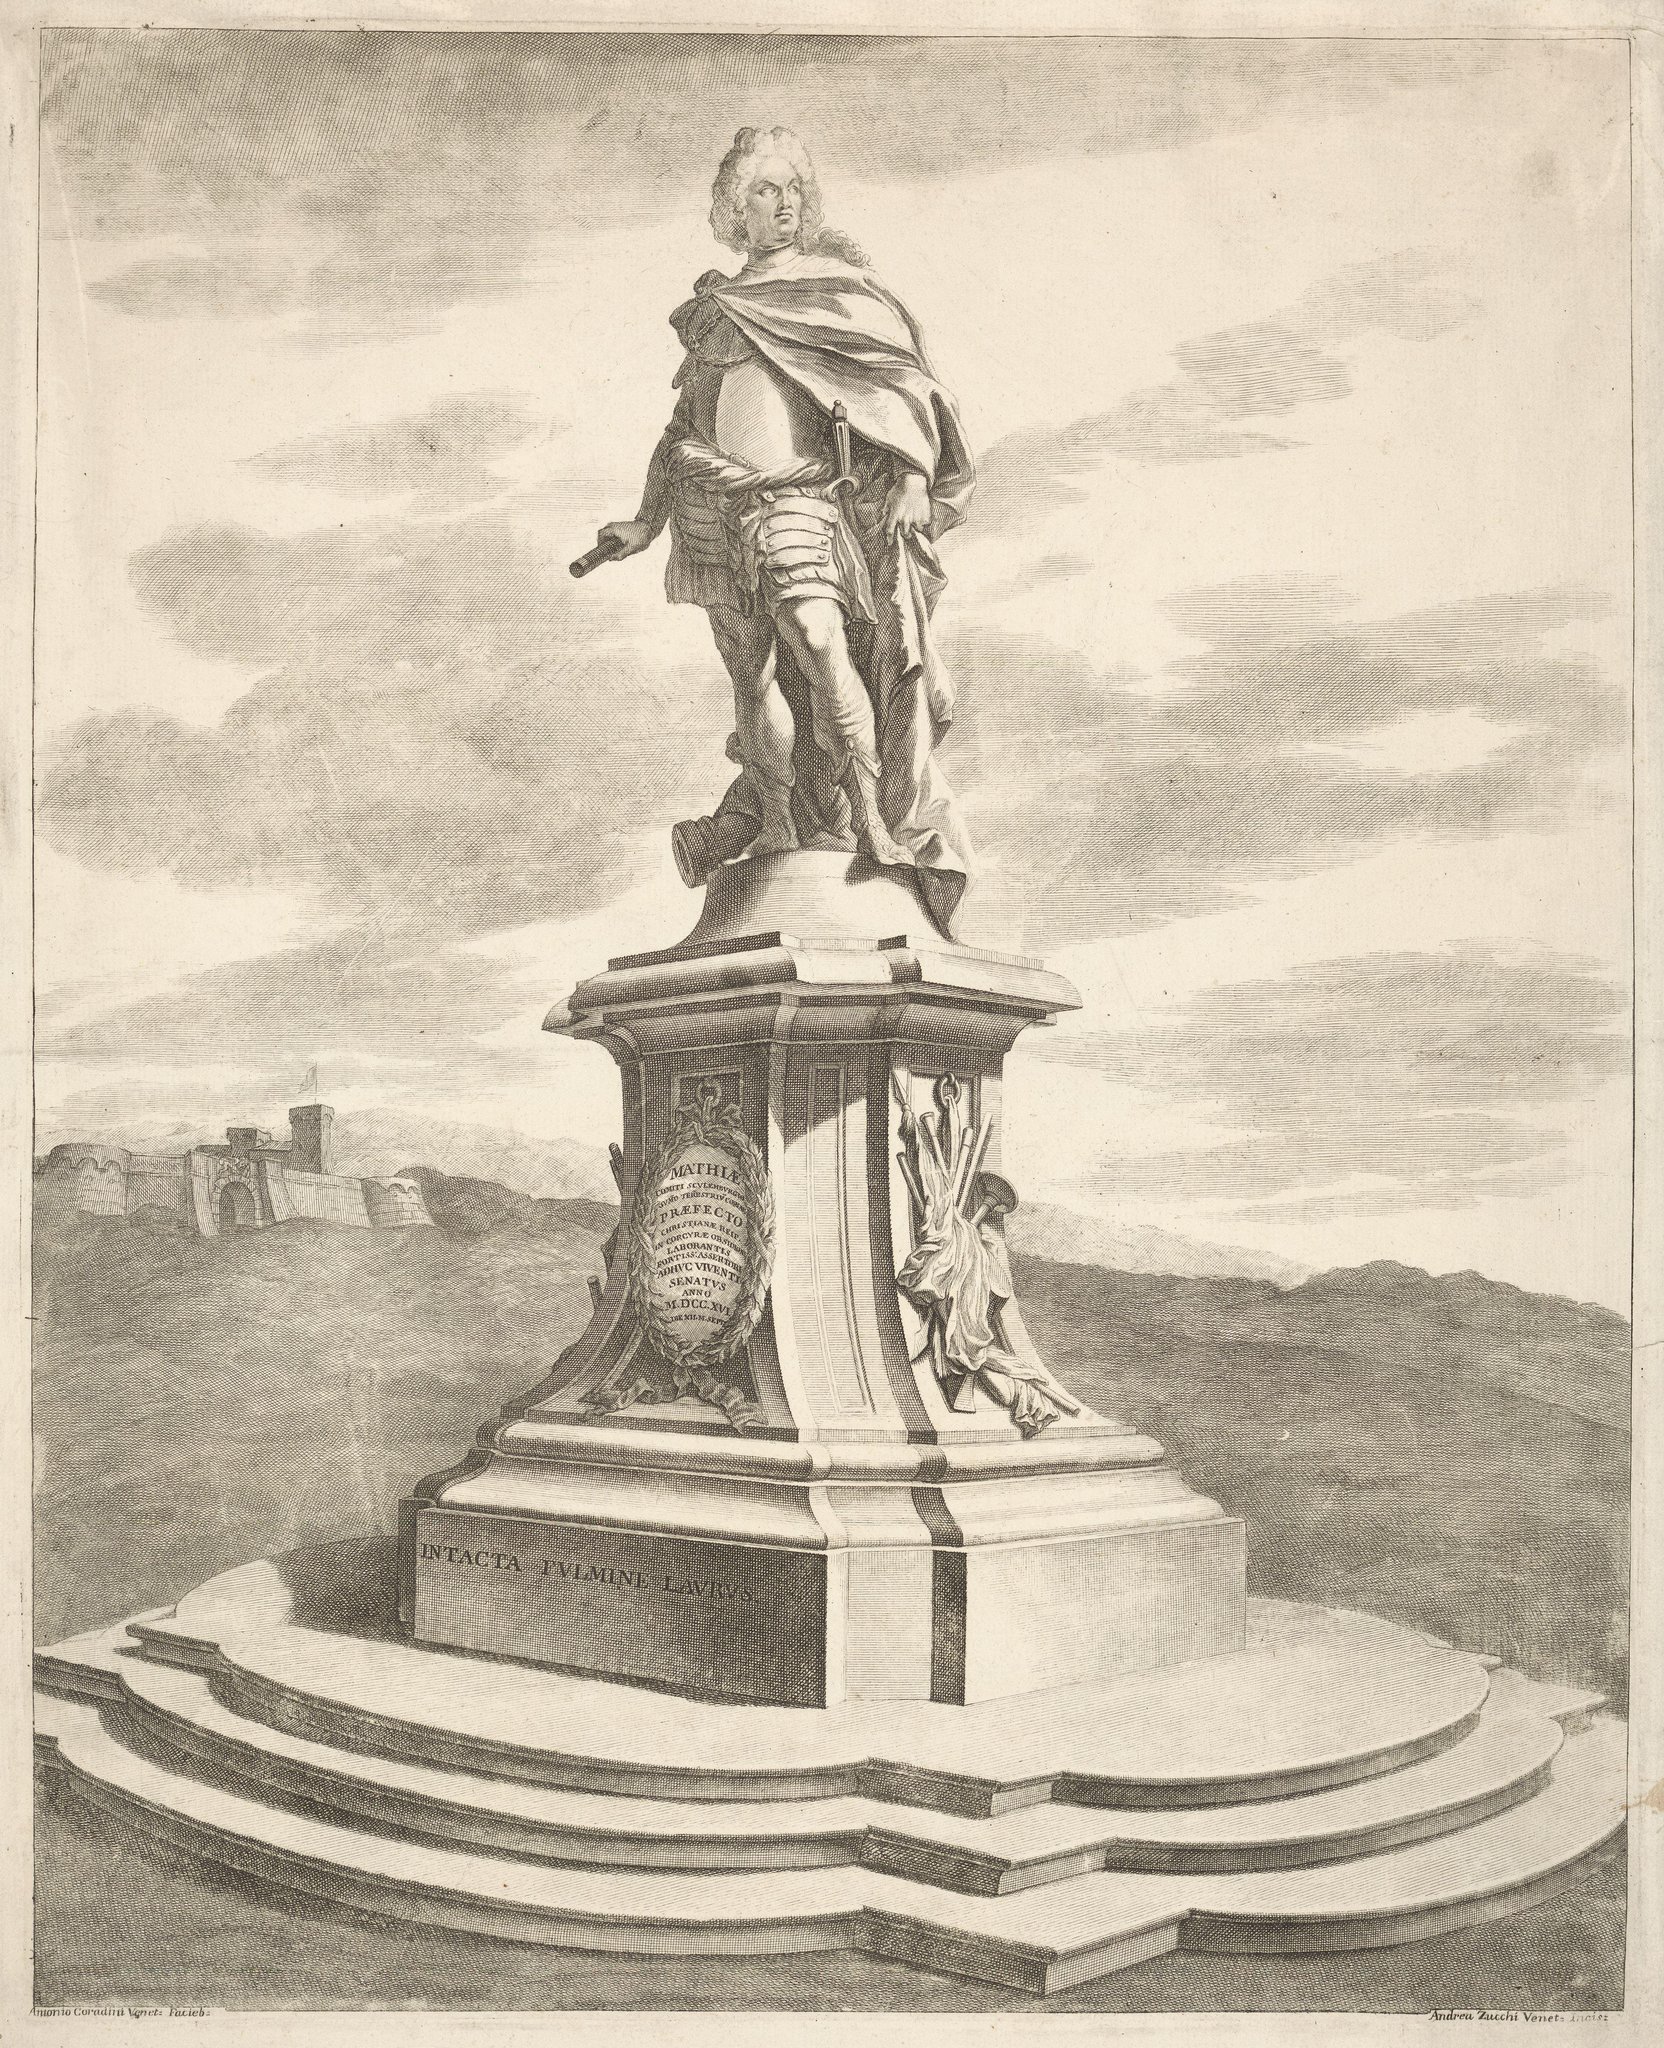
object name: print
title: Standbeeld op sokkel van Matthias Johann von der Schulenburg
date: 1689-1740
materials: paper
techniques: engraving, etching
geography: venice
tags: historical persons, piece of sculpture, reproduction of a piece of sculpture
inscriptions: collector's mark: Lugt 2228